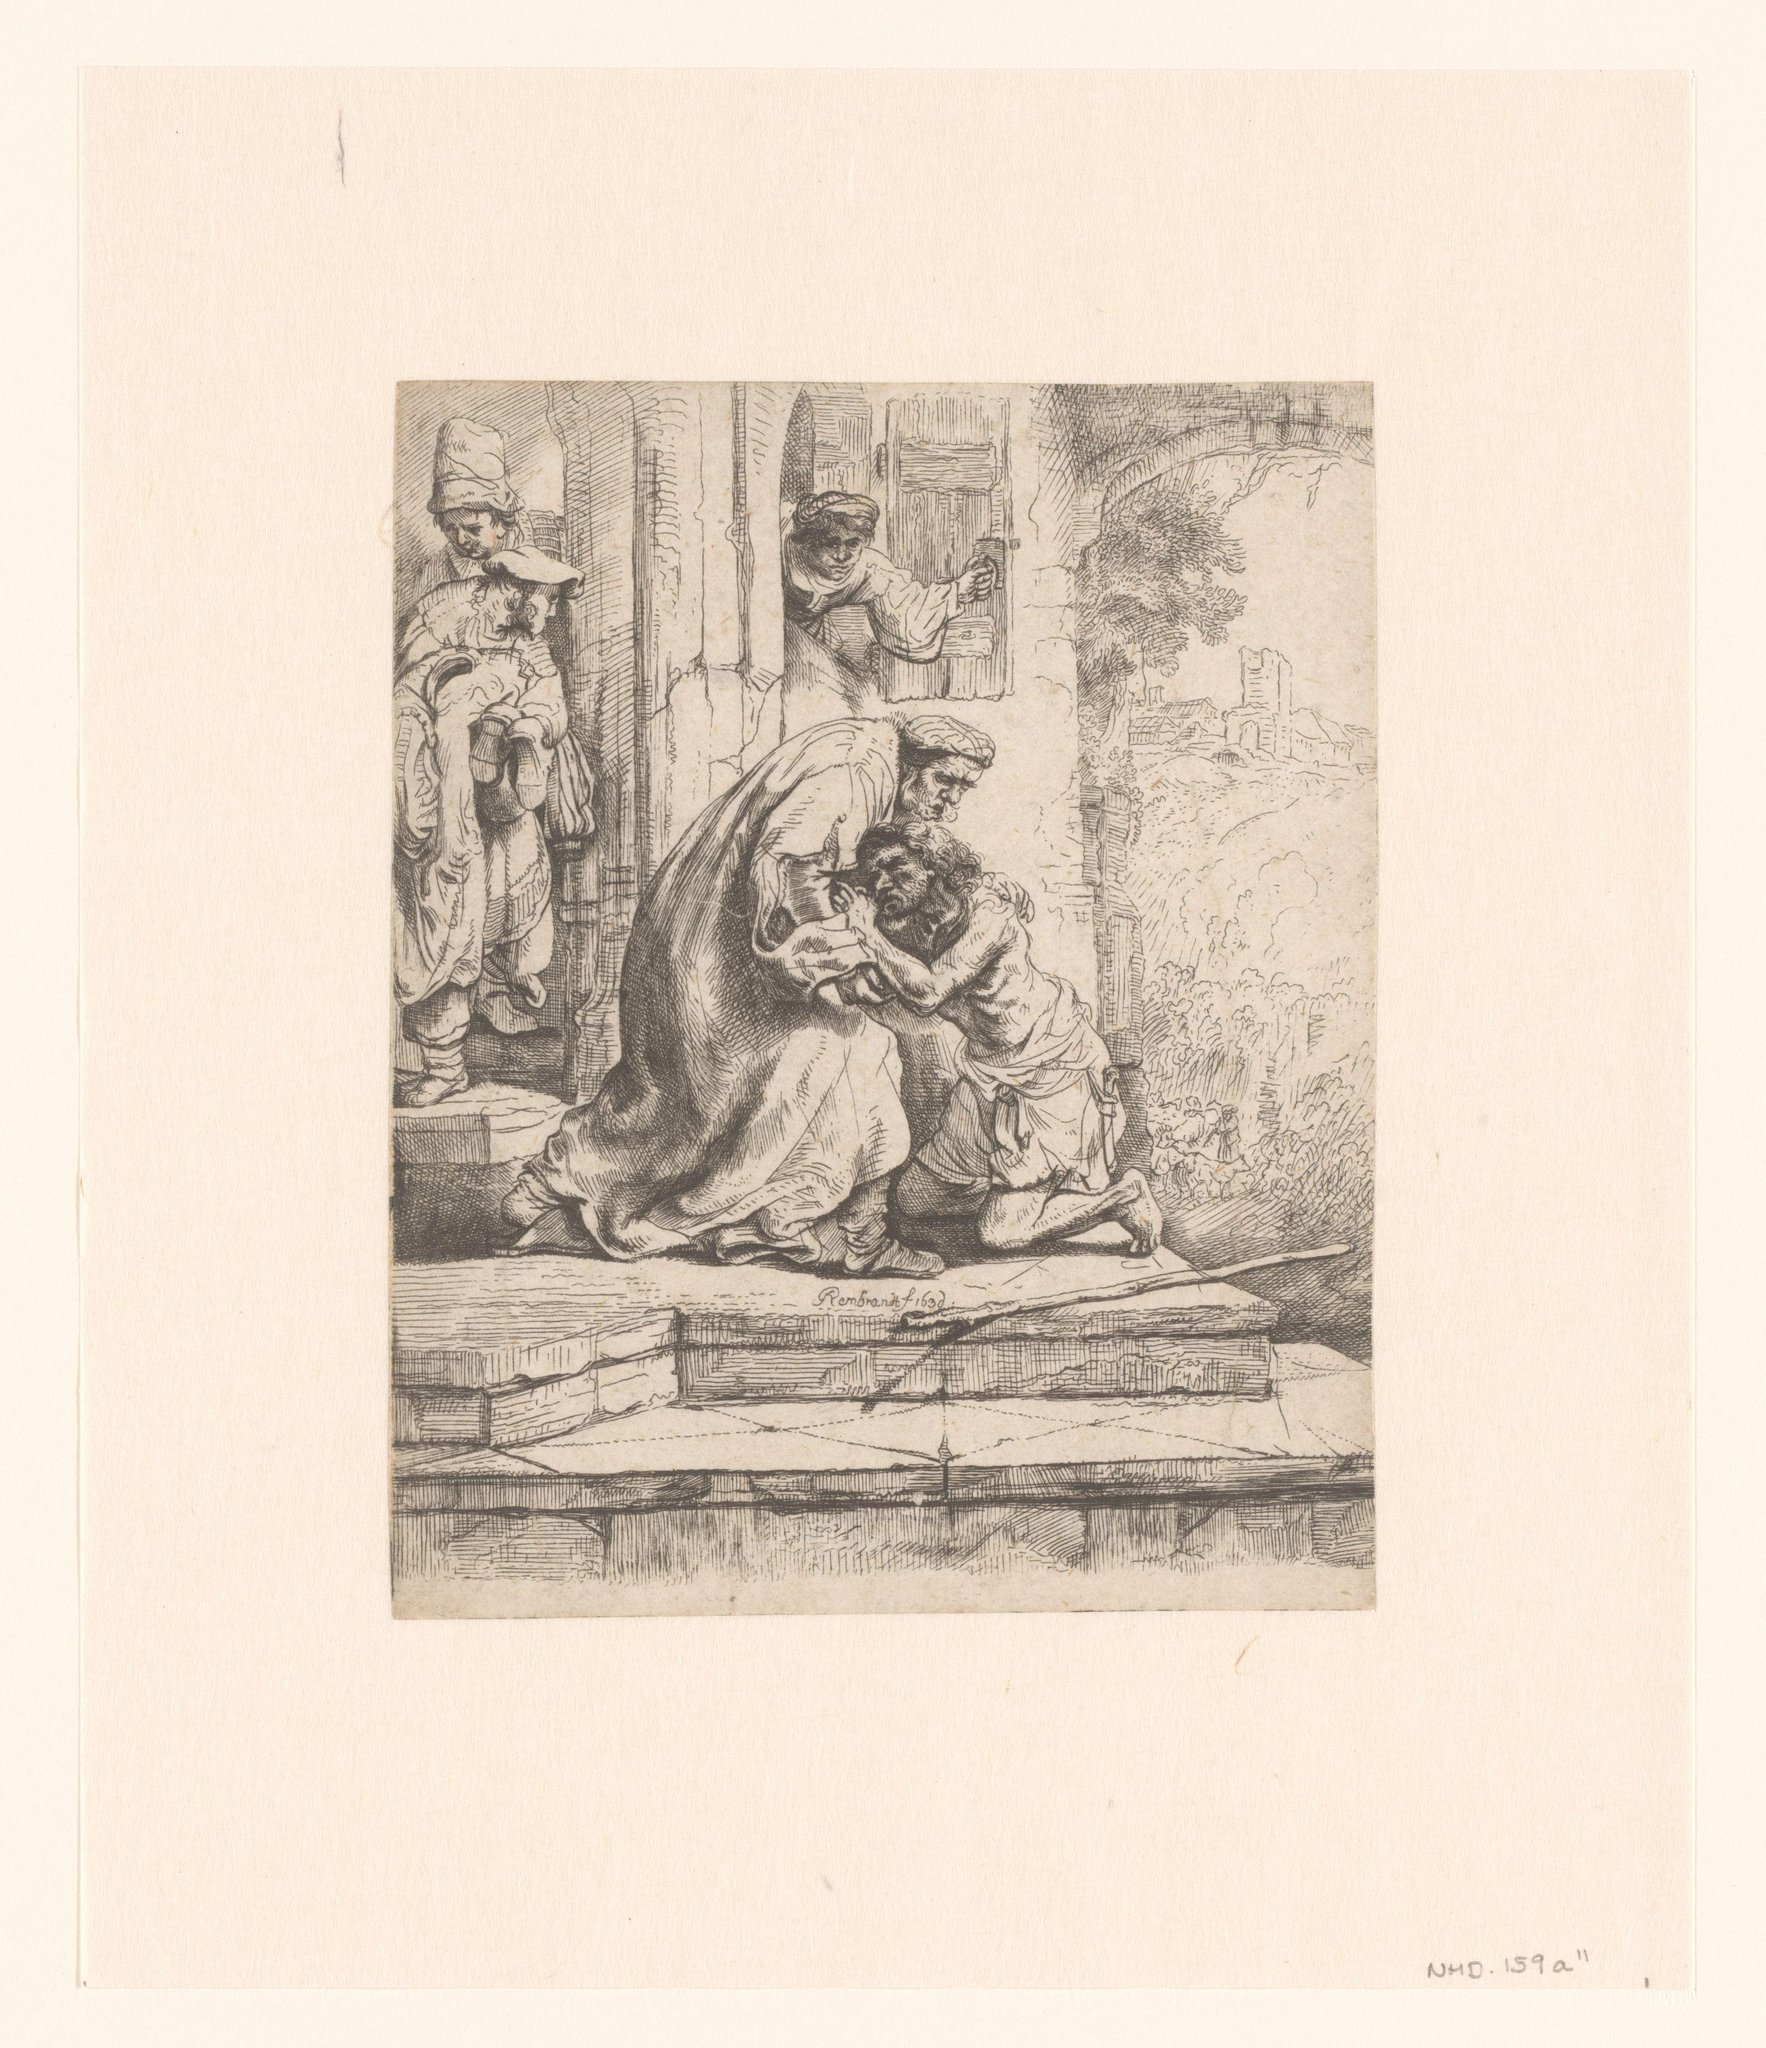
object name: print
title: The return of the prodigal son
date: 1711-1800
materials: paper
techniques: etching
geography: augsburg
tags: the parable of the prodigal son (luke 15:11-32)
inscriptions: collector's mark: Lugt 2228, collector's mark: Lugt 2760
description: Spiegelbeeldige kopie naar de gelijknamige prent van Rembrandt.